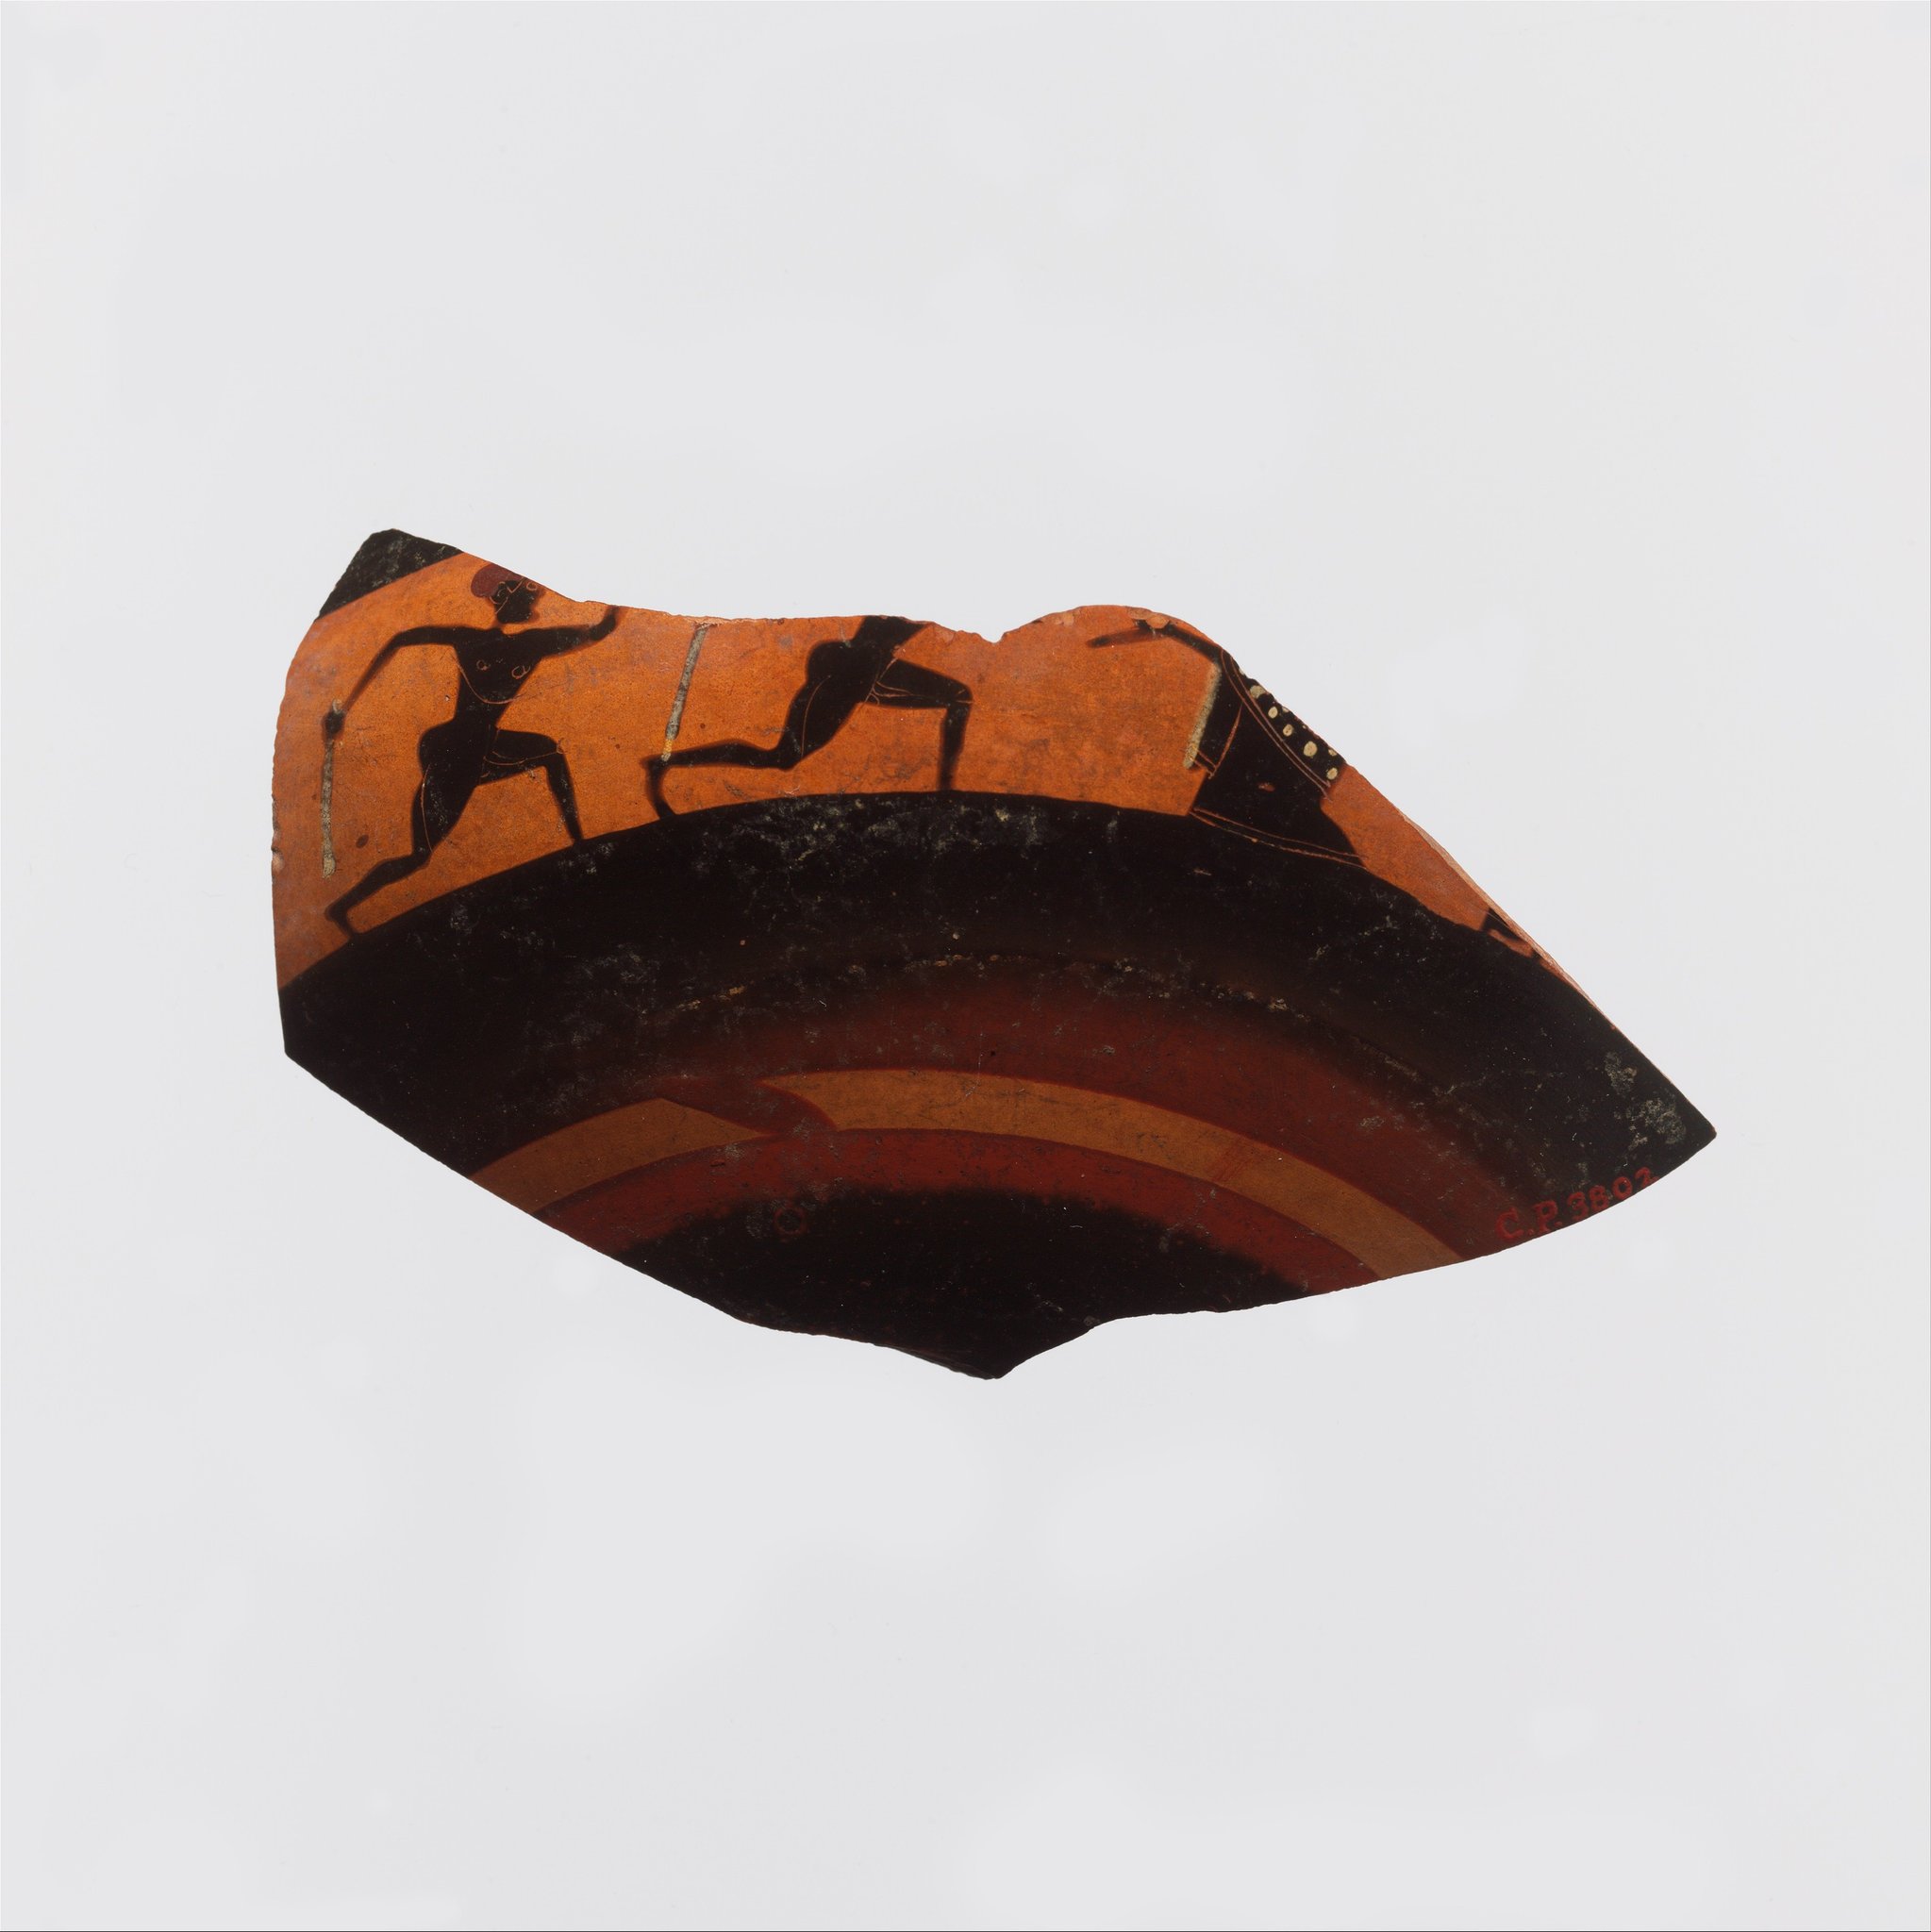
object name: kylix, band cup fragment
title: Fragment of a kylix: band-cup (drinking cup)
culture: greek, attic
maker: elbows out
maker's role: artist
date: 550-525 BCE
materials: terracotta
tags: human figures